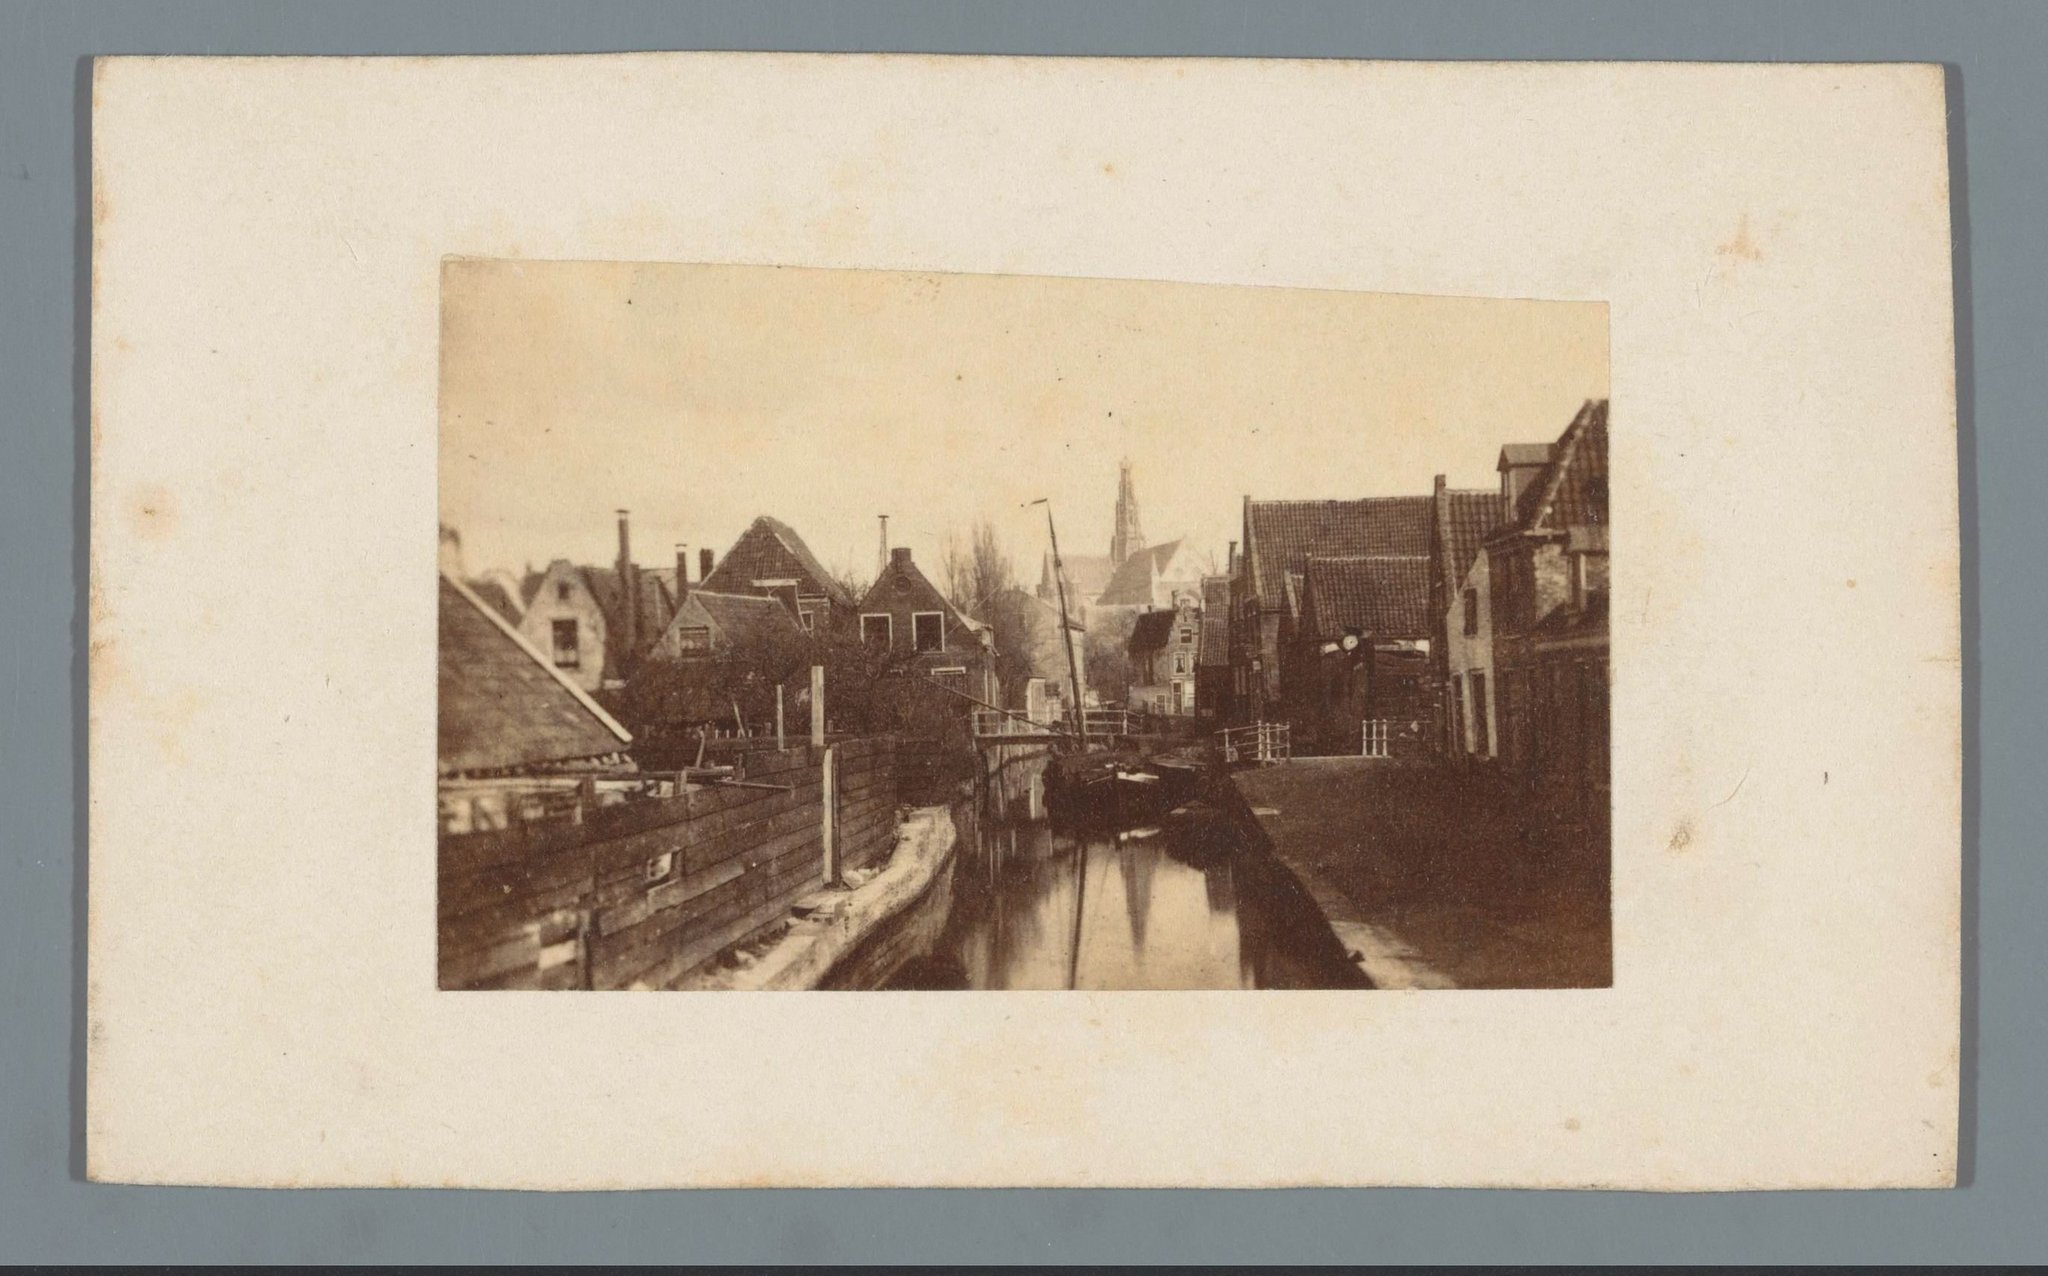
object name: photograph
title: Gezicht op Haarlem met de Grote Kerk of de Sint-Bavokerk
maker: Anonymous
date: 1850-1900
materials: cardboard, photographic support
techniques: albumen print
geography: haarlem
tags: city-view in general; 'veduta', church (exterior), canals, waters (in city)